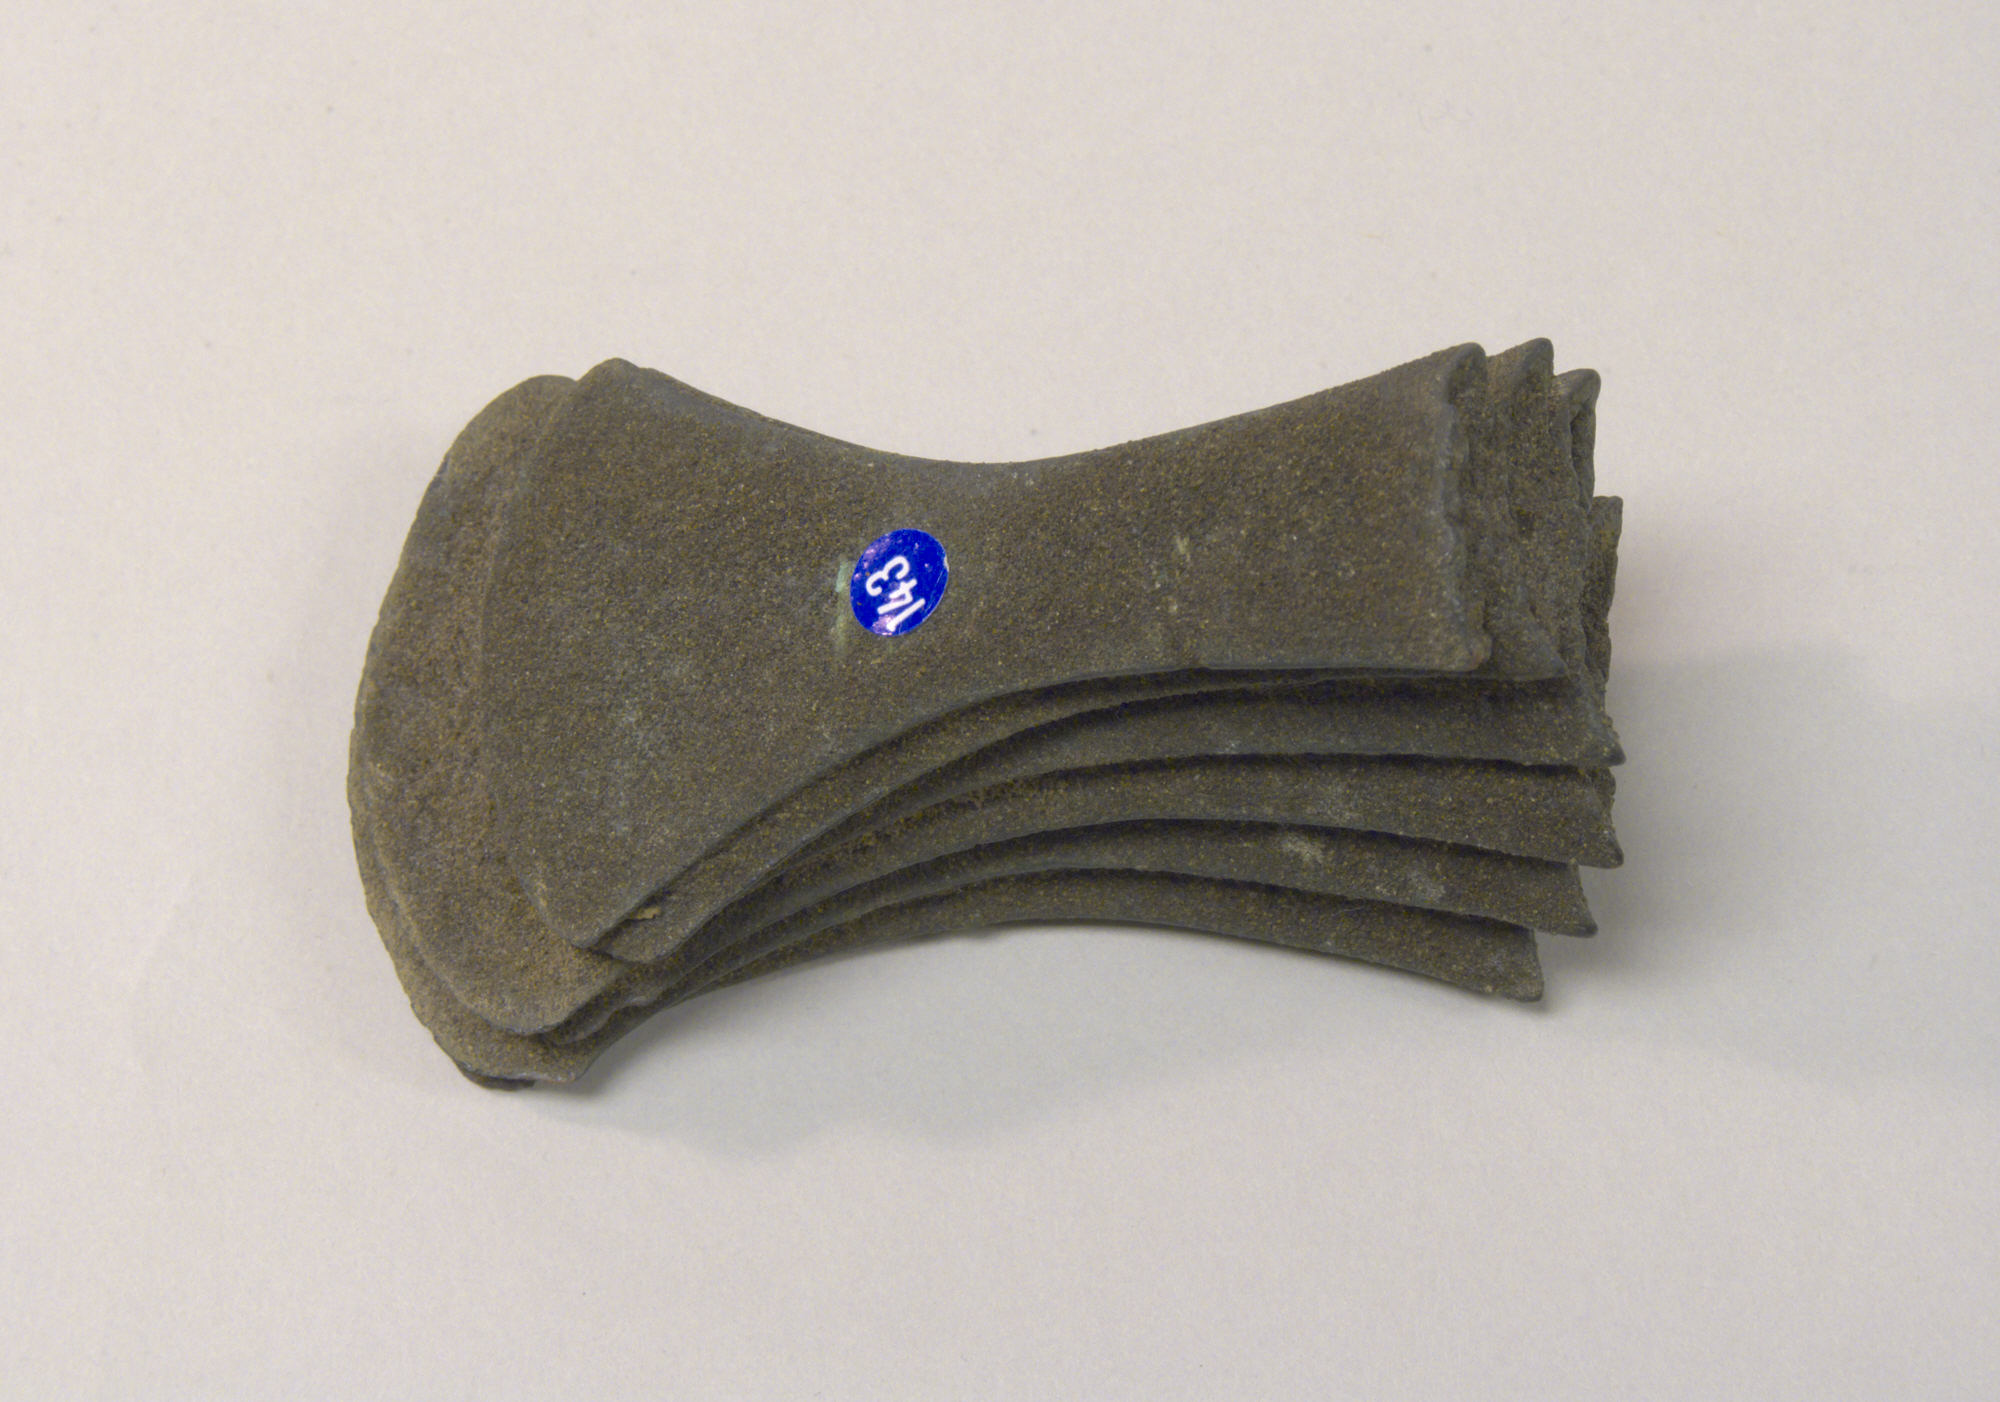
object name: token ax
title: Token Axes in the Shape of a Fask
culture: indonesian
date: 500 BCE-300 CE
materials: bronze